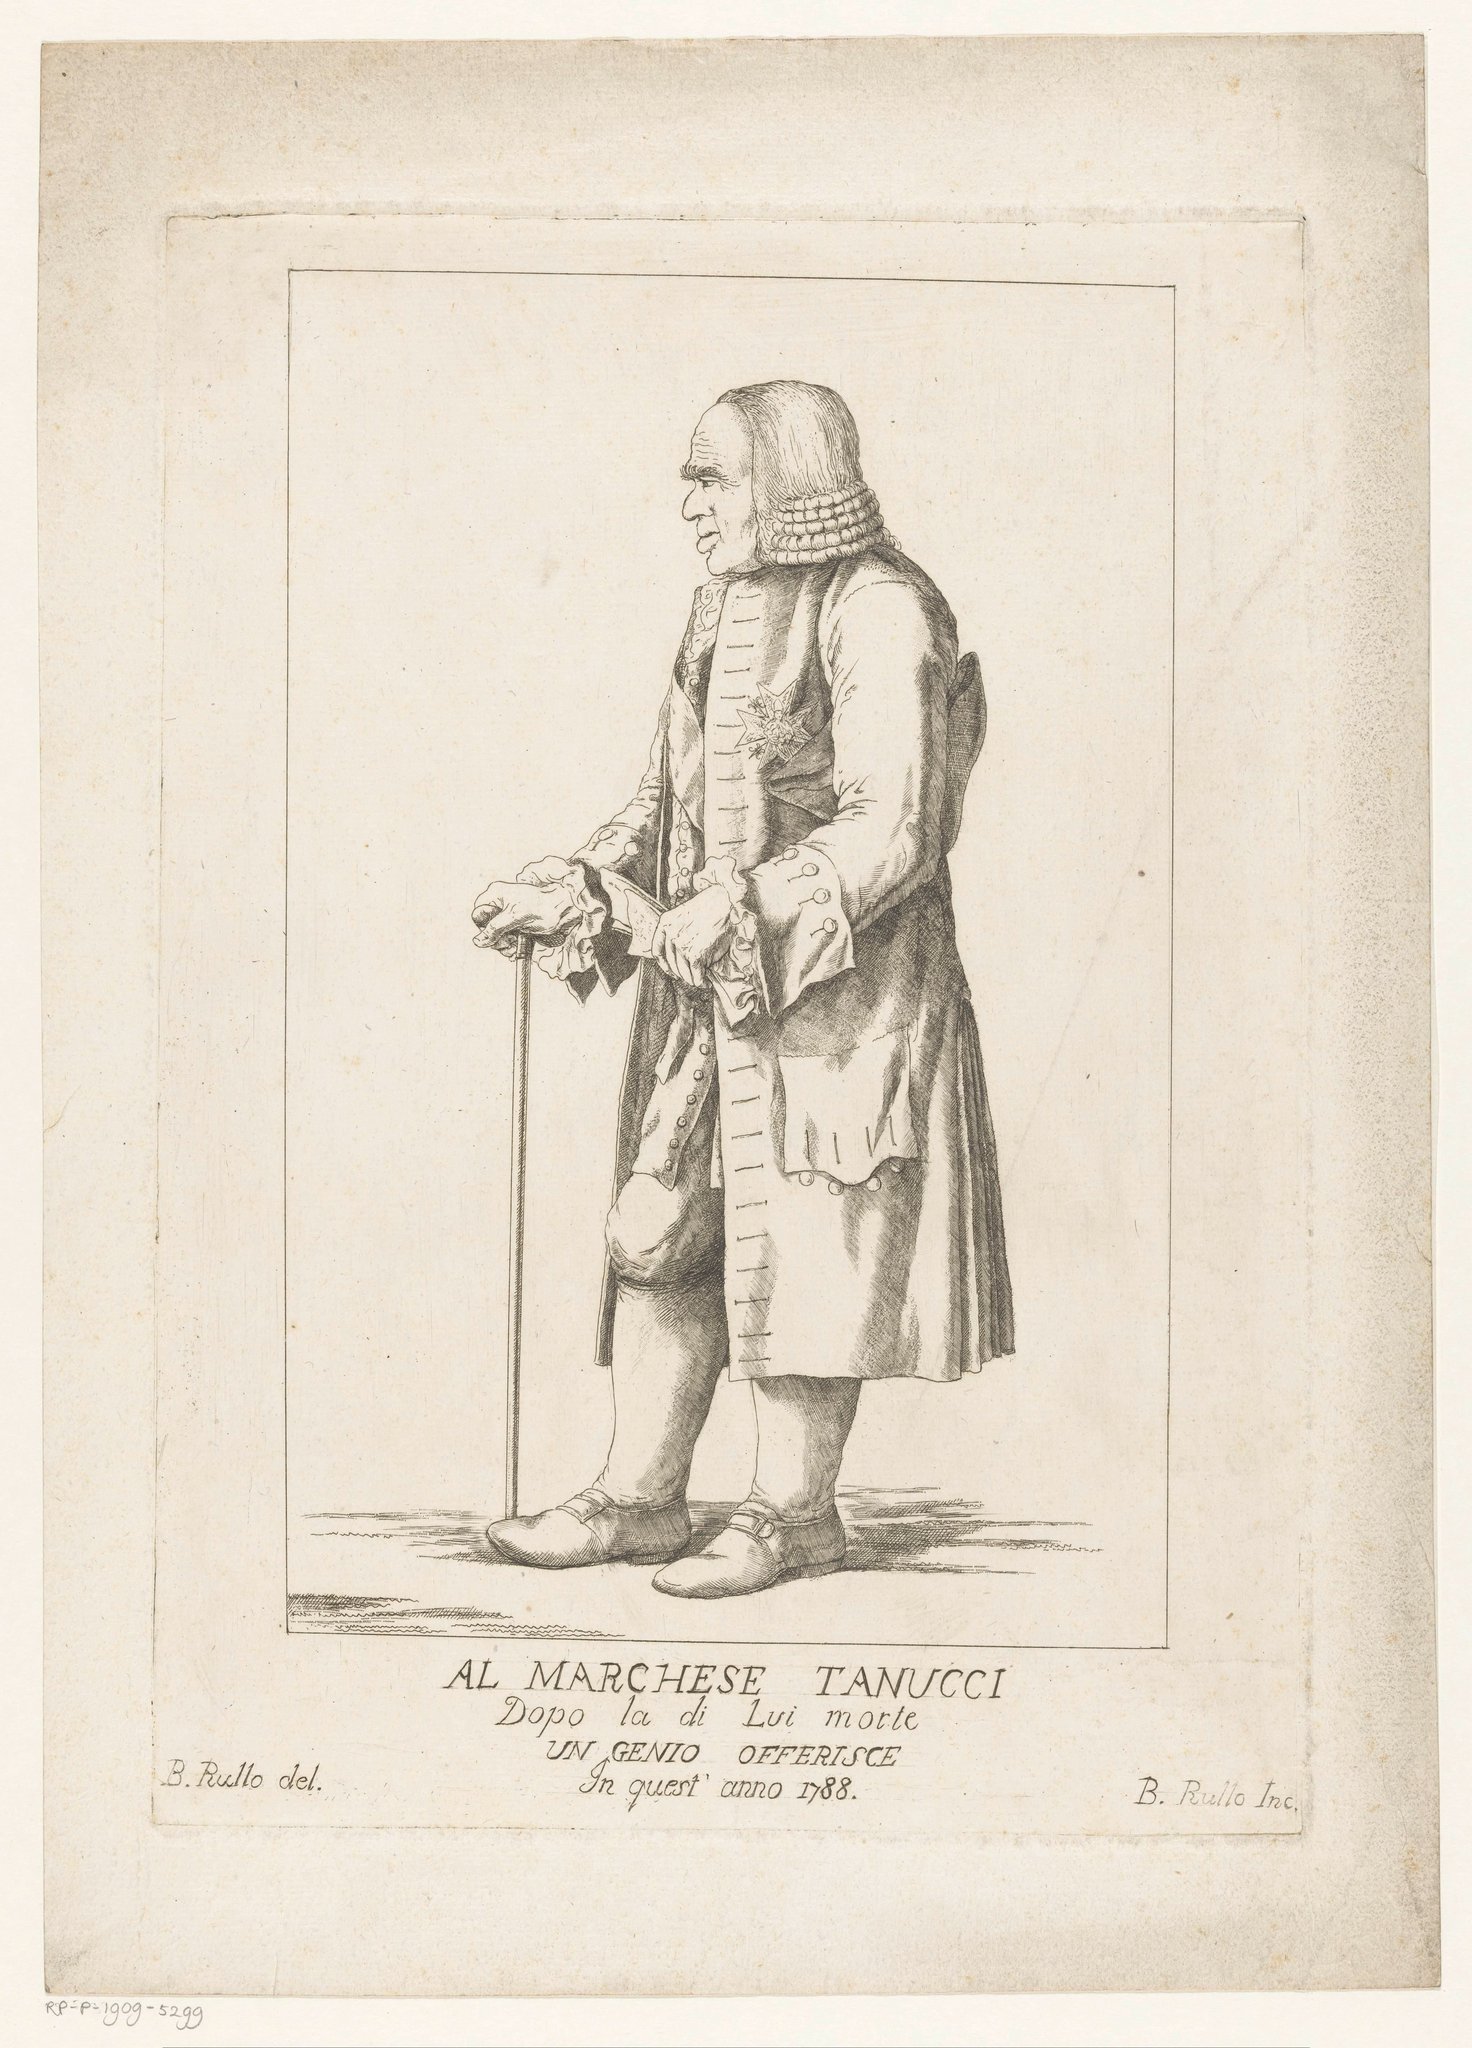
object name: print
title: Portret van Bernardo Tanucci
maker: b. rullo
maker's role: print maker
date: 1788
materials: paper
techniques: etching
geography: italy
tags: italy, politician, historical persons, politician, e.g. party leader, ruler, sovereign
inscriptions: collector's mark: Lugt 2228